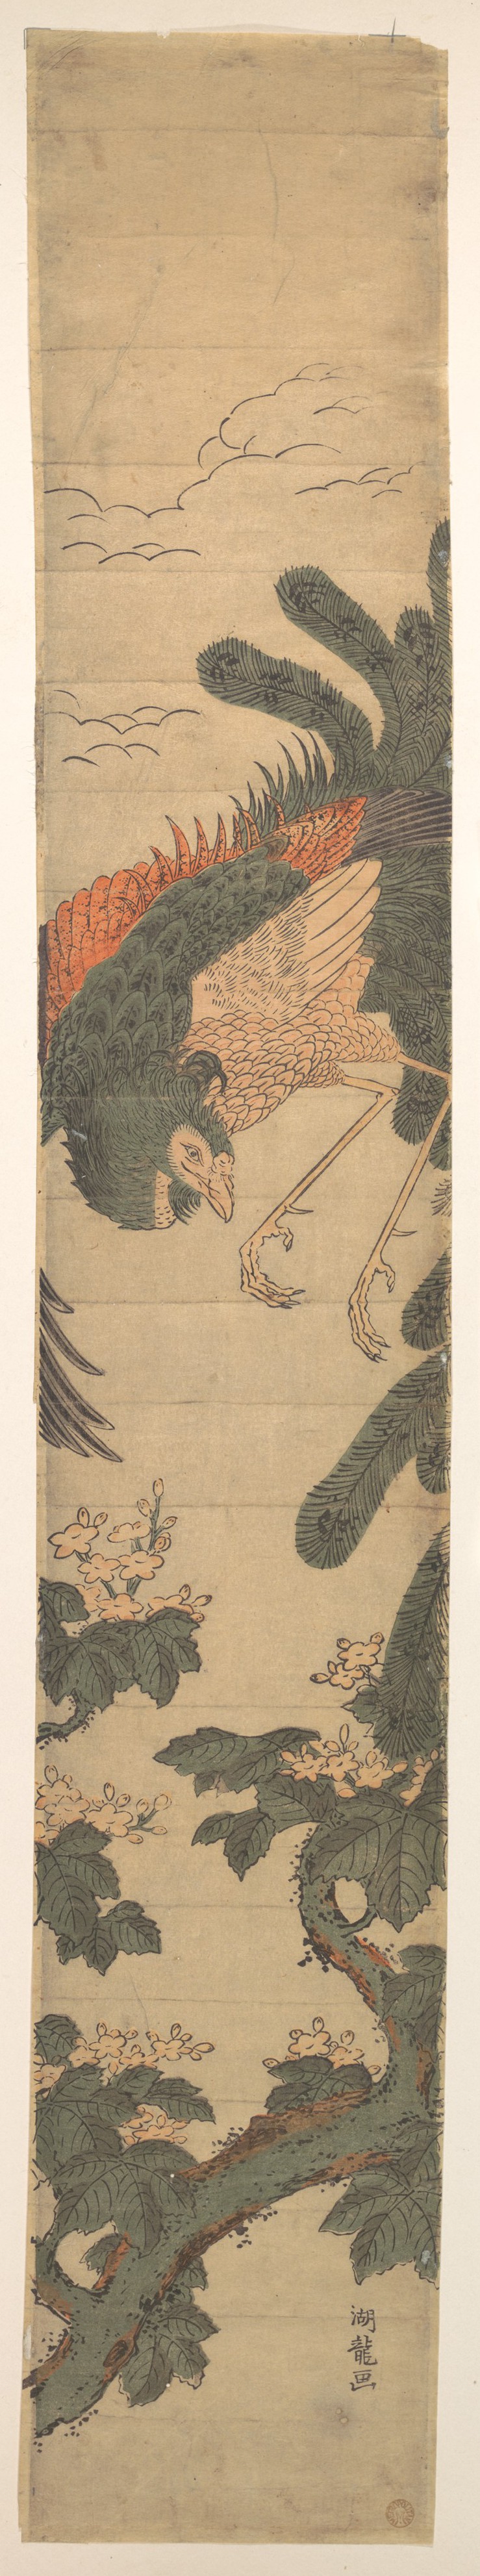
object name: print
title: Phoenix Flying Over a Paulownia Tree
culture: japanese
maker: isoda koryūsai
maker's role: artist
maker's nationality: japanese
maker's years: 1735-1790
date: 1770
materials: ink, paper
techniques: woodblock print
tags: birds